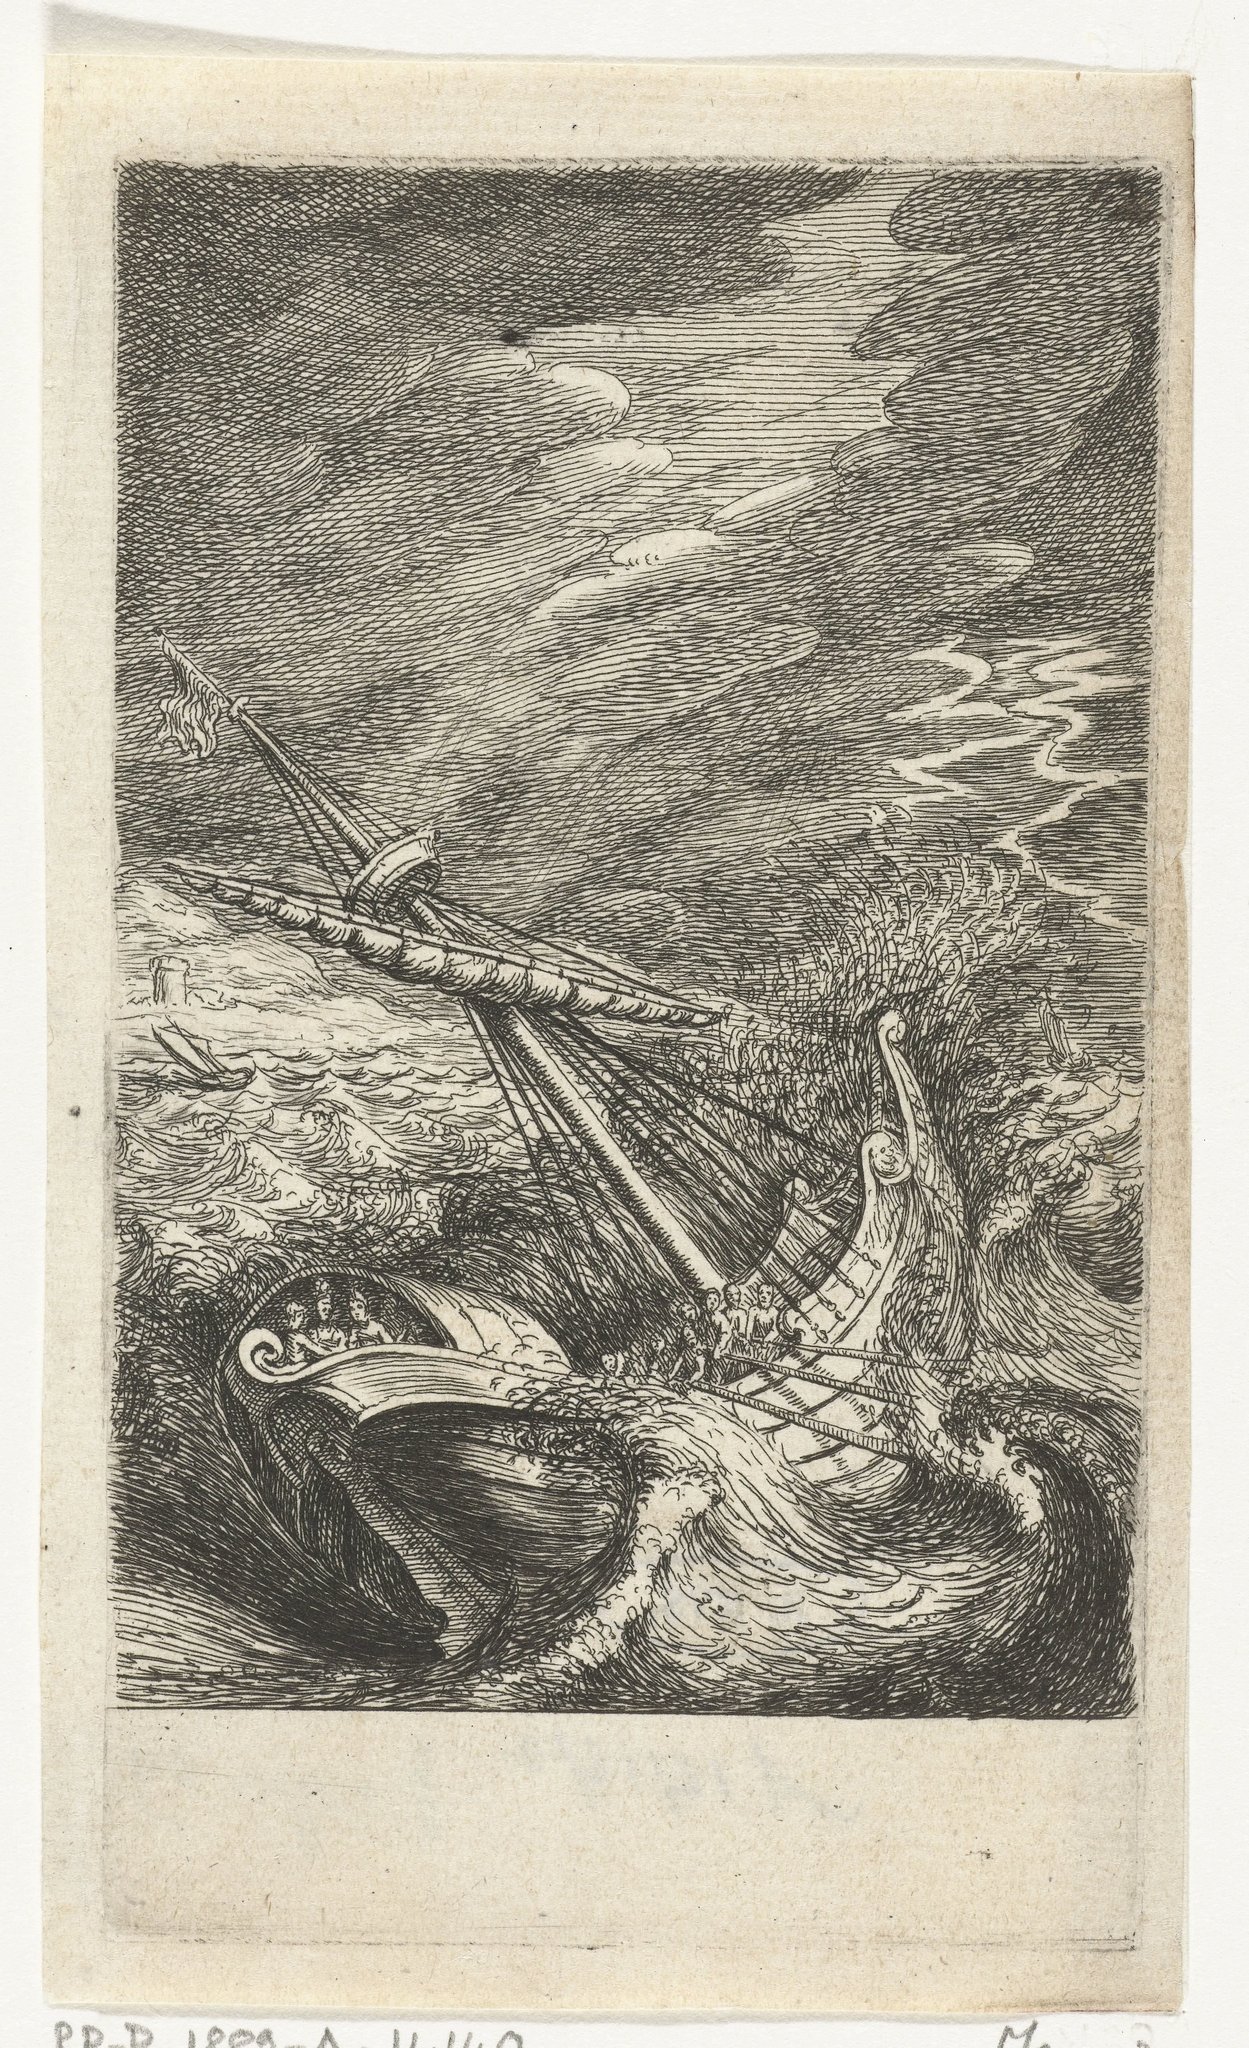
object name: print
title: Schip op zee in een onweersbui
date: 1648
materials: paper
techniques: etching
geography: amsterdam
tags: sailing-ship, sailing-boat, storm at sea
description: Boekillustratie voor: Lambert van den Bos, Batavias, of Batavische Aeneas, Amsterdam, Jacob Lescaille, 1648